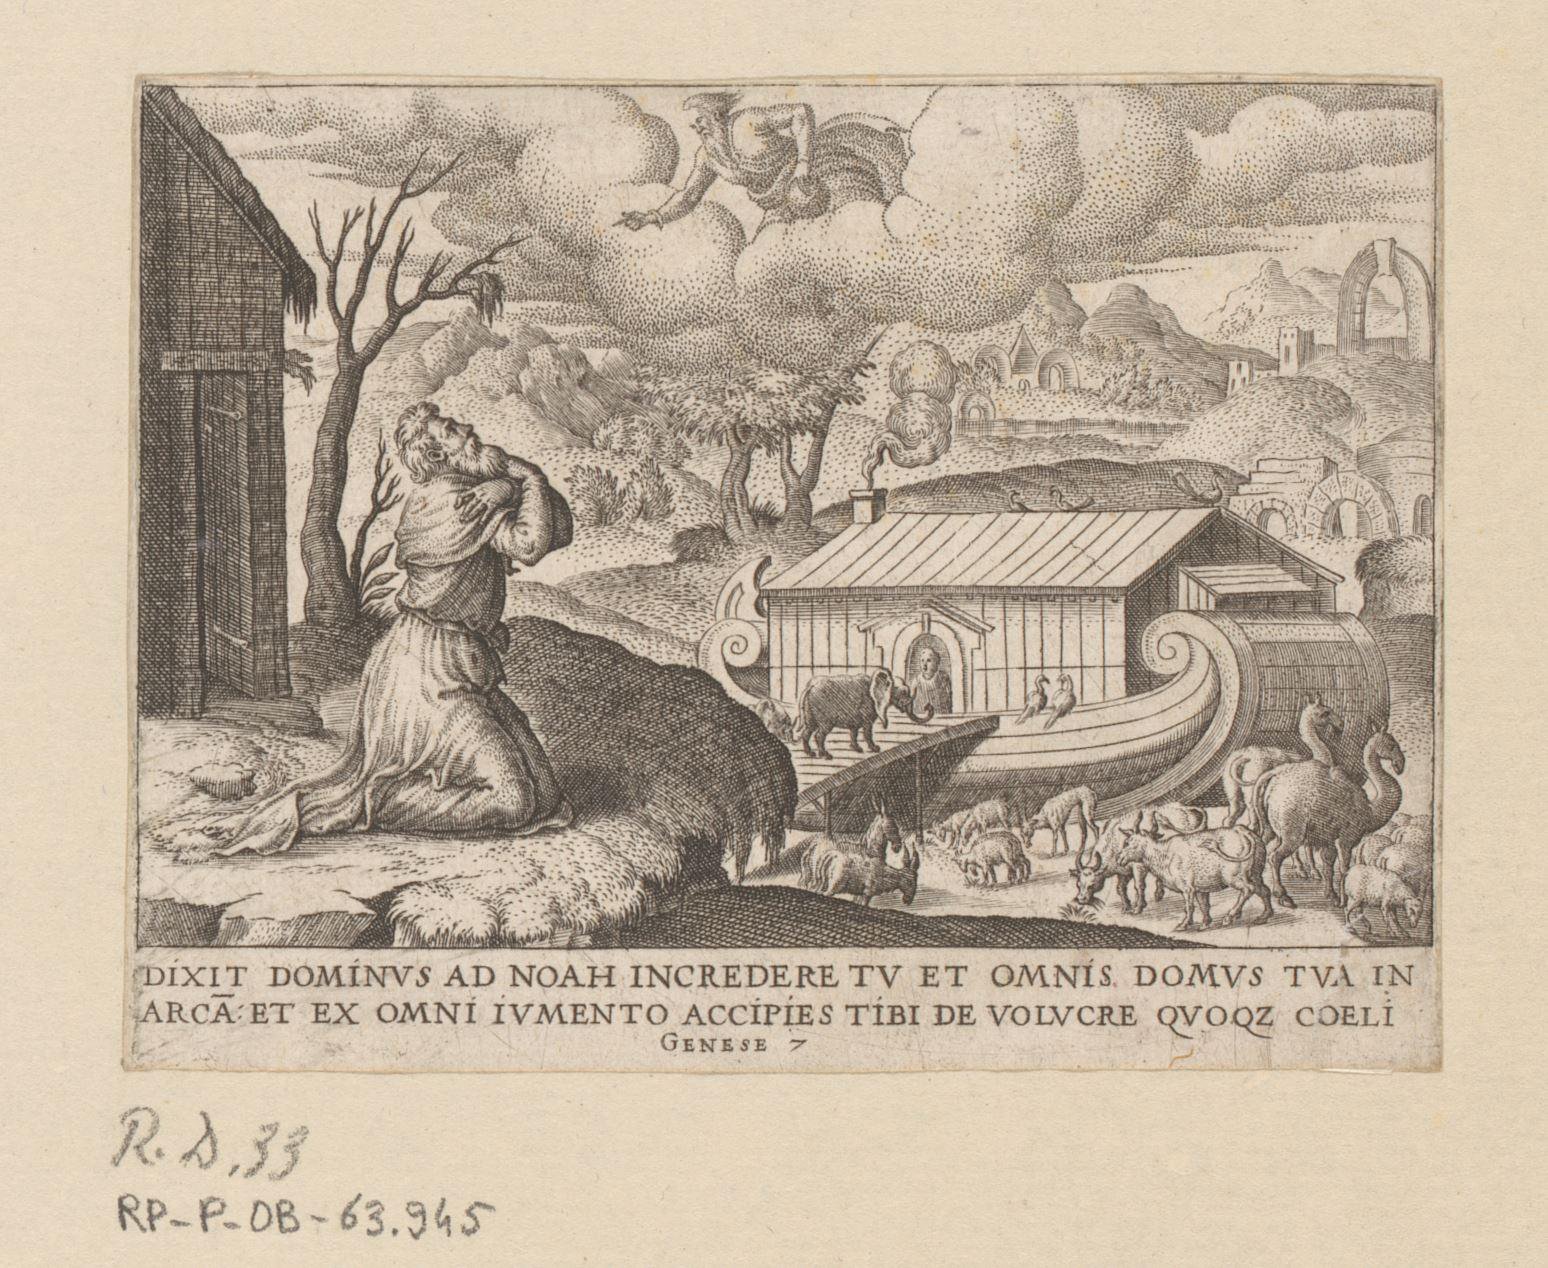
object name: print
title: God draagt Noach op de ark te bouwen en te betreden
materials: paper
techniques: engraving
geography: france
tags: god announces a flood and commands noah to build an ark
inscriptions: collector's mark: Lugt 240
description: Maakt deel uit van een serie met mogelijk kopieën naar prenten door Etienne Delaune met illustraties bij de Genesis.